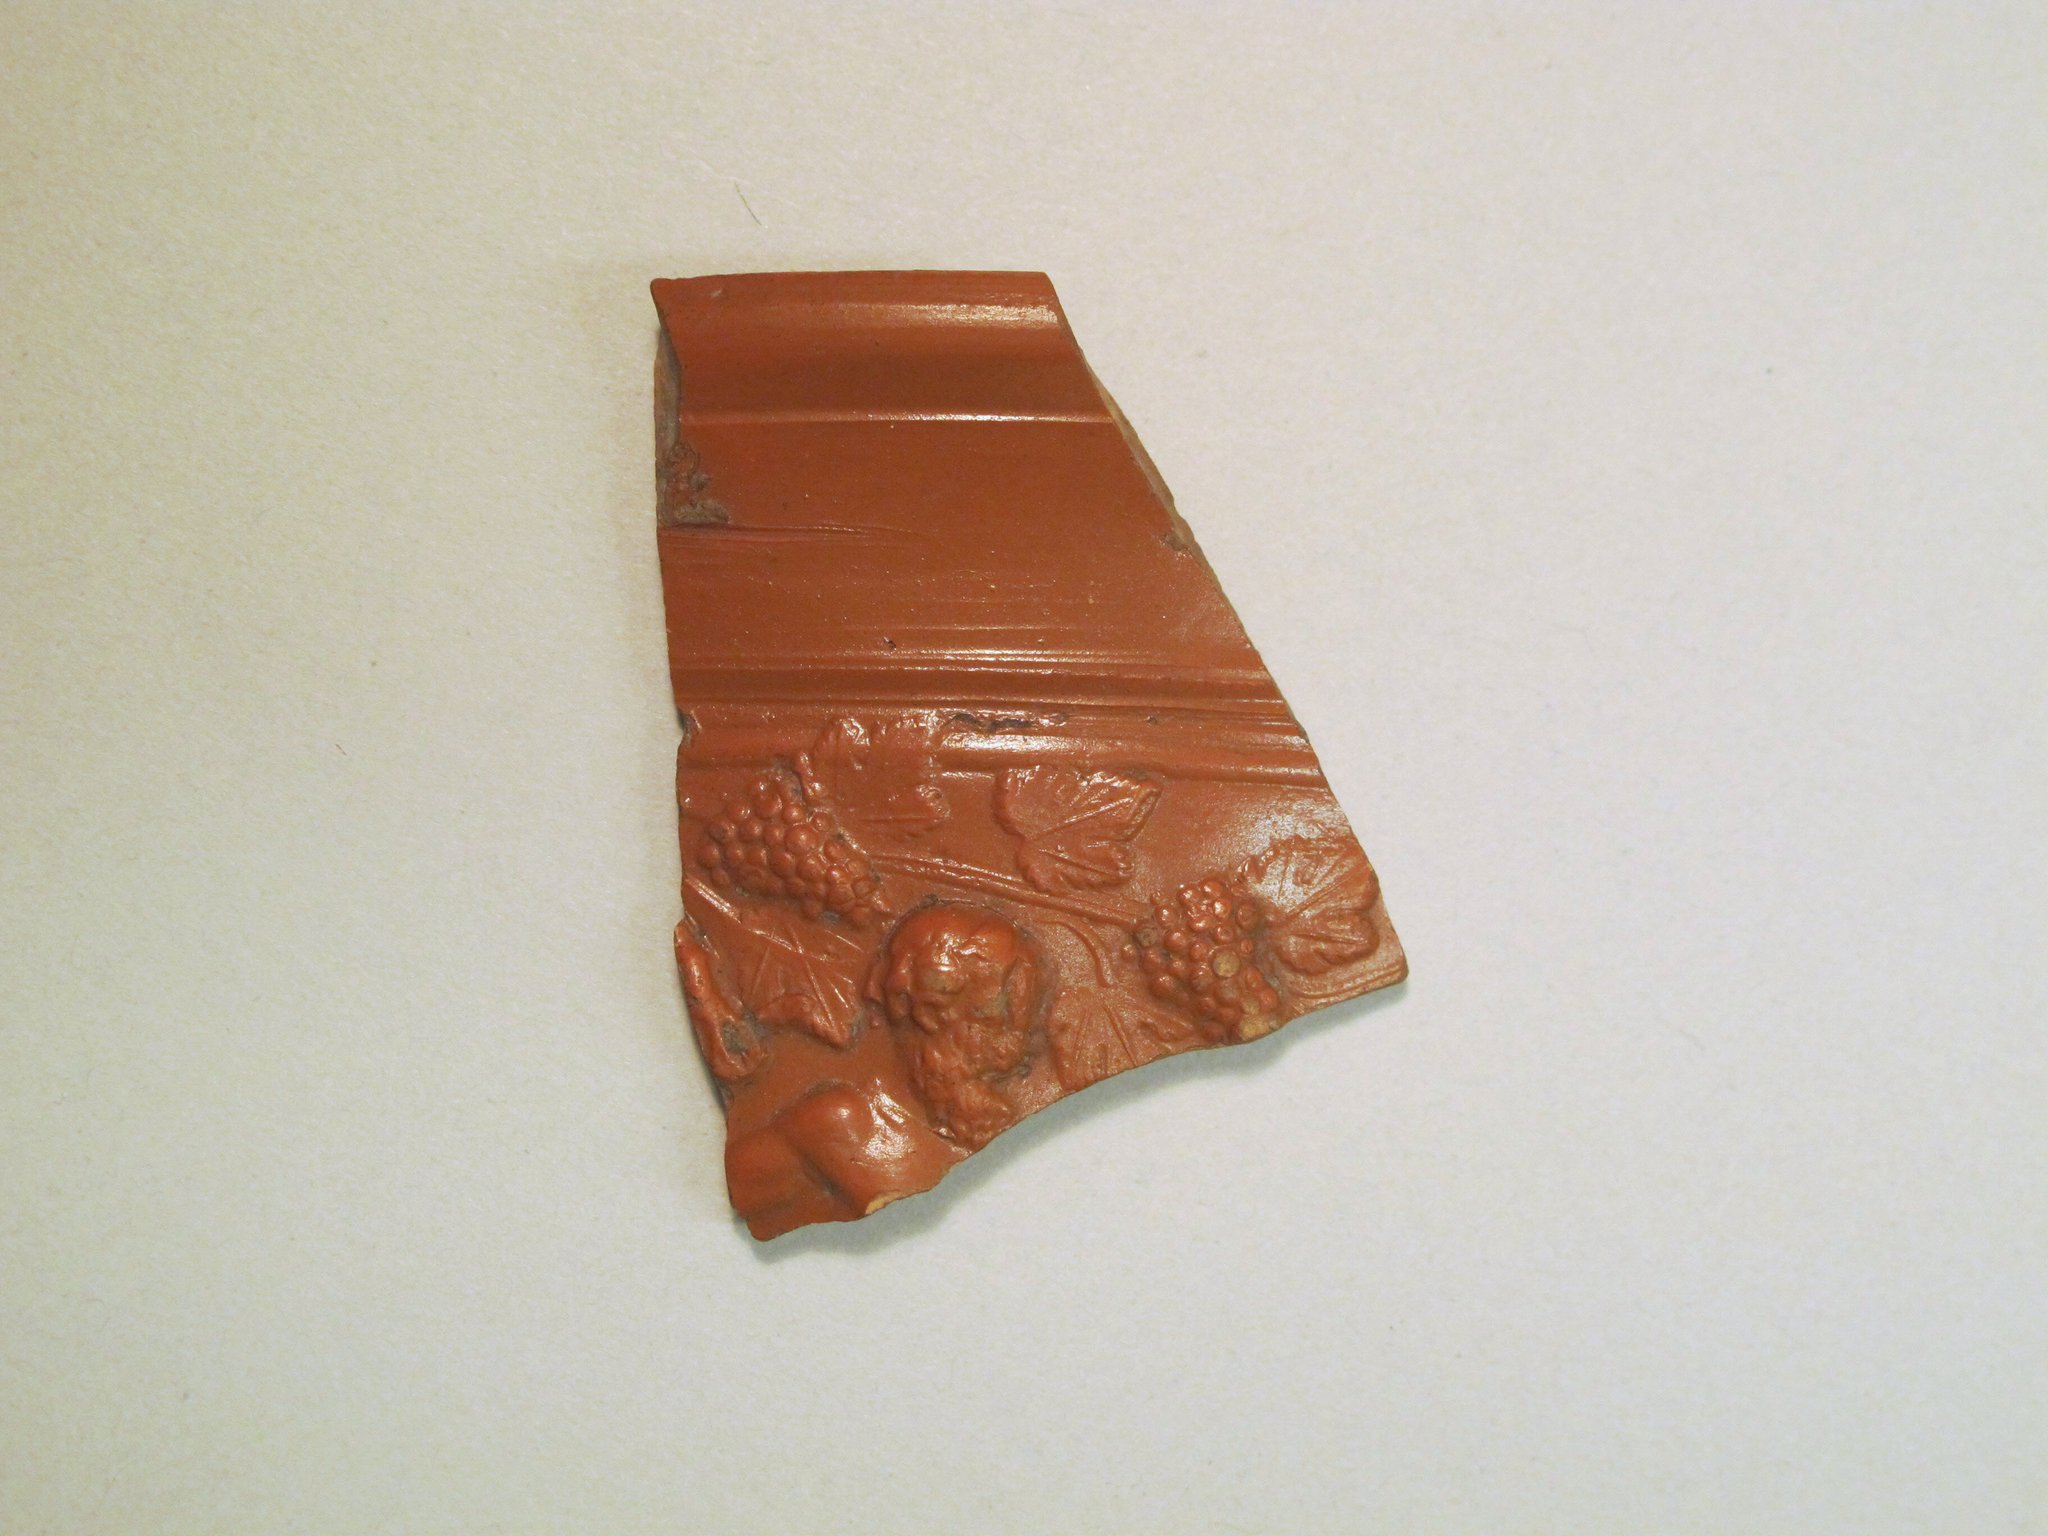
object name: vase fragment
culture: roman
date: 670 BCE-330 CE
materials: terracotta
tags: grapes,satyrs